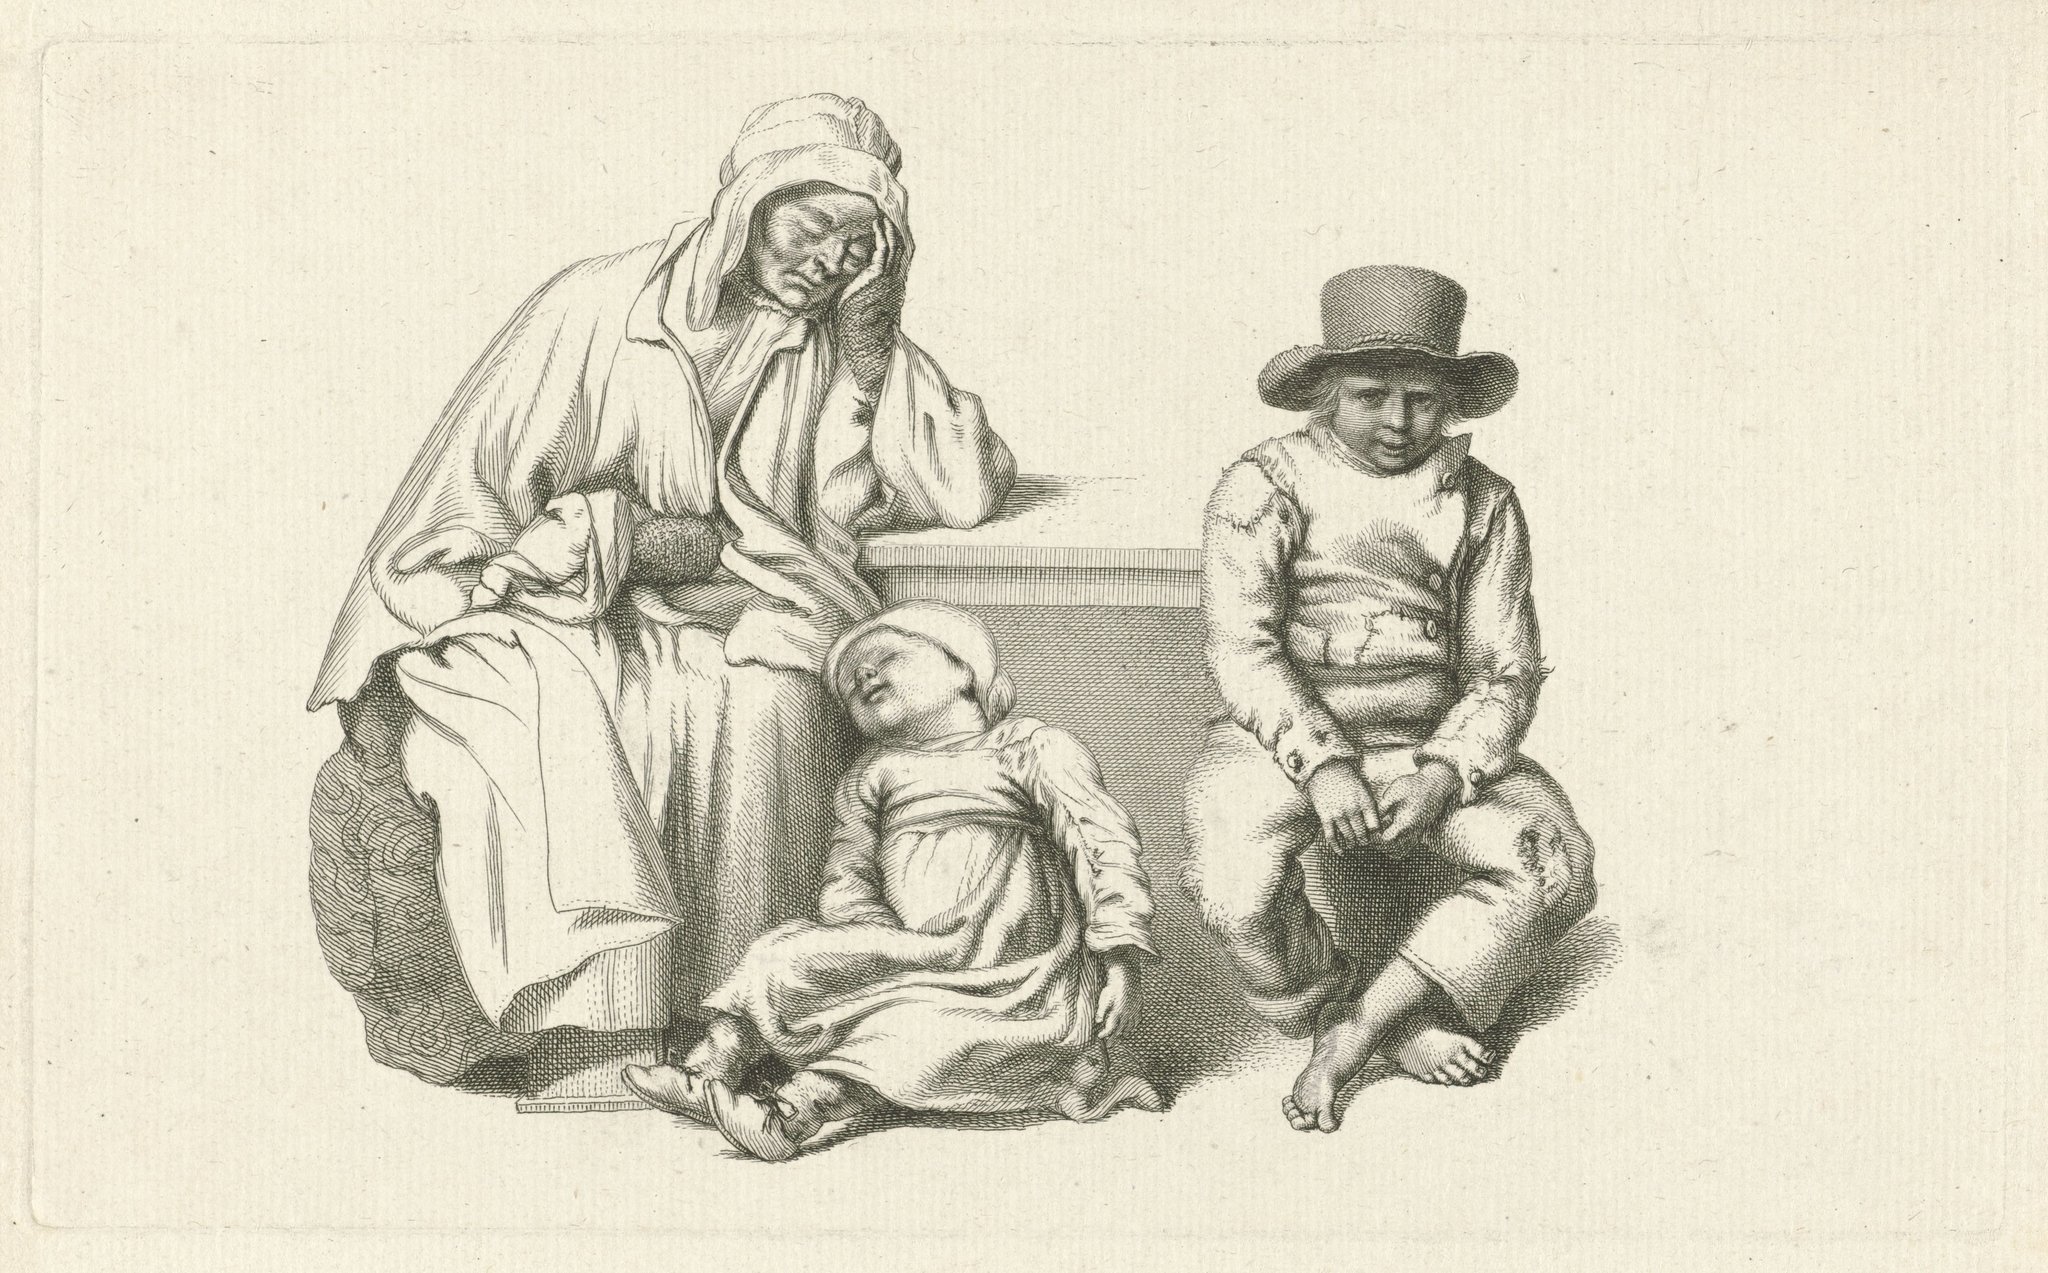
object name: print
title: Zittende oude vrouw en twee kinderen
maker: jacob ernst marcus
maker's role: draughtsman, print maker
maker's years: 1774-1826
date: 1813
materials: paper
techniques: etching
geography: amsterdam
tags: child, old woman, sleeping; unconsciousness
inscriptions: collector's mark: Lugt 2228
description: Een zittende oude vrouw rust met haar hoofd tegen haar hand, haar voet op een voetstoof. Naast haar een slapend meisje, links een jongen.